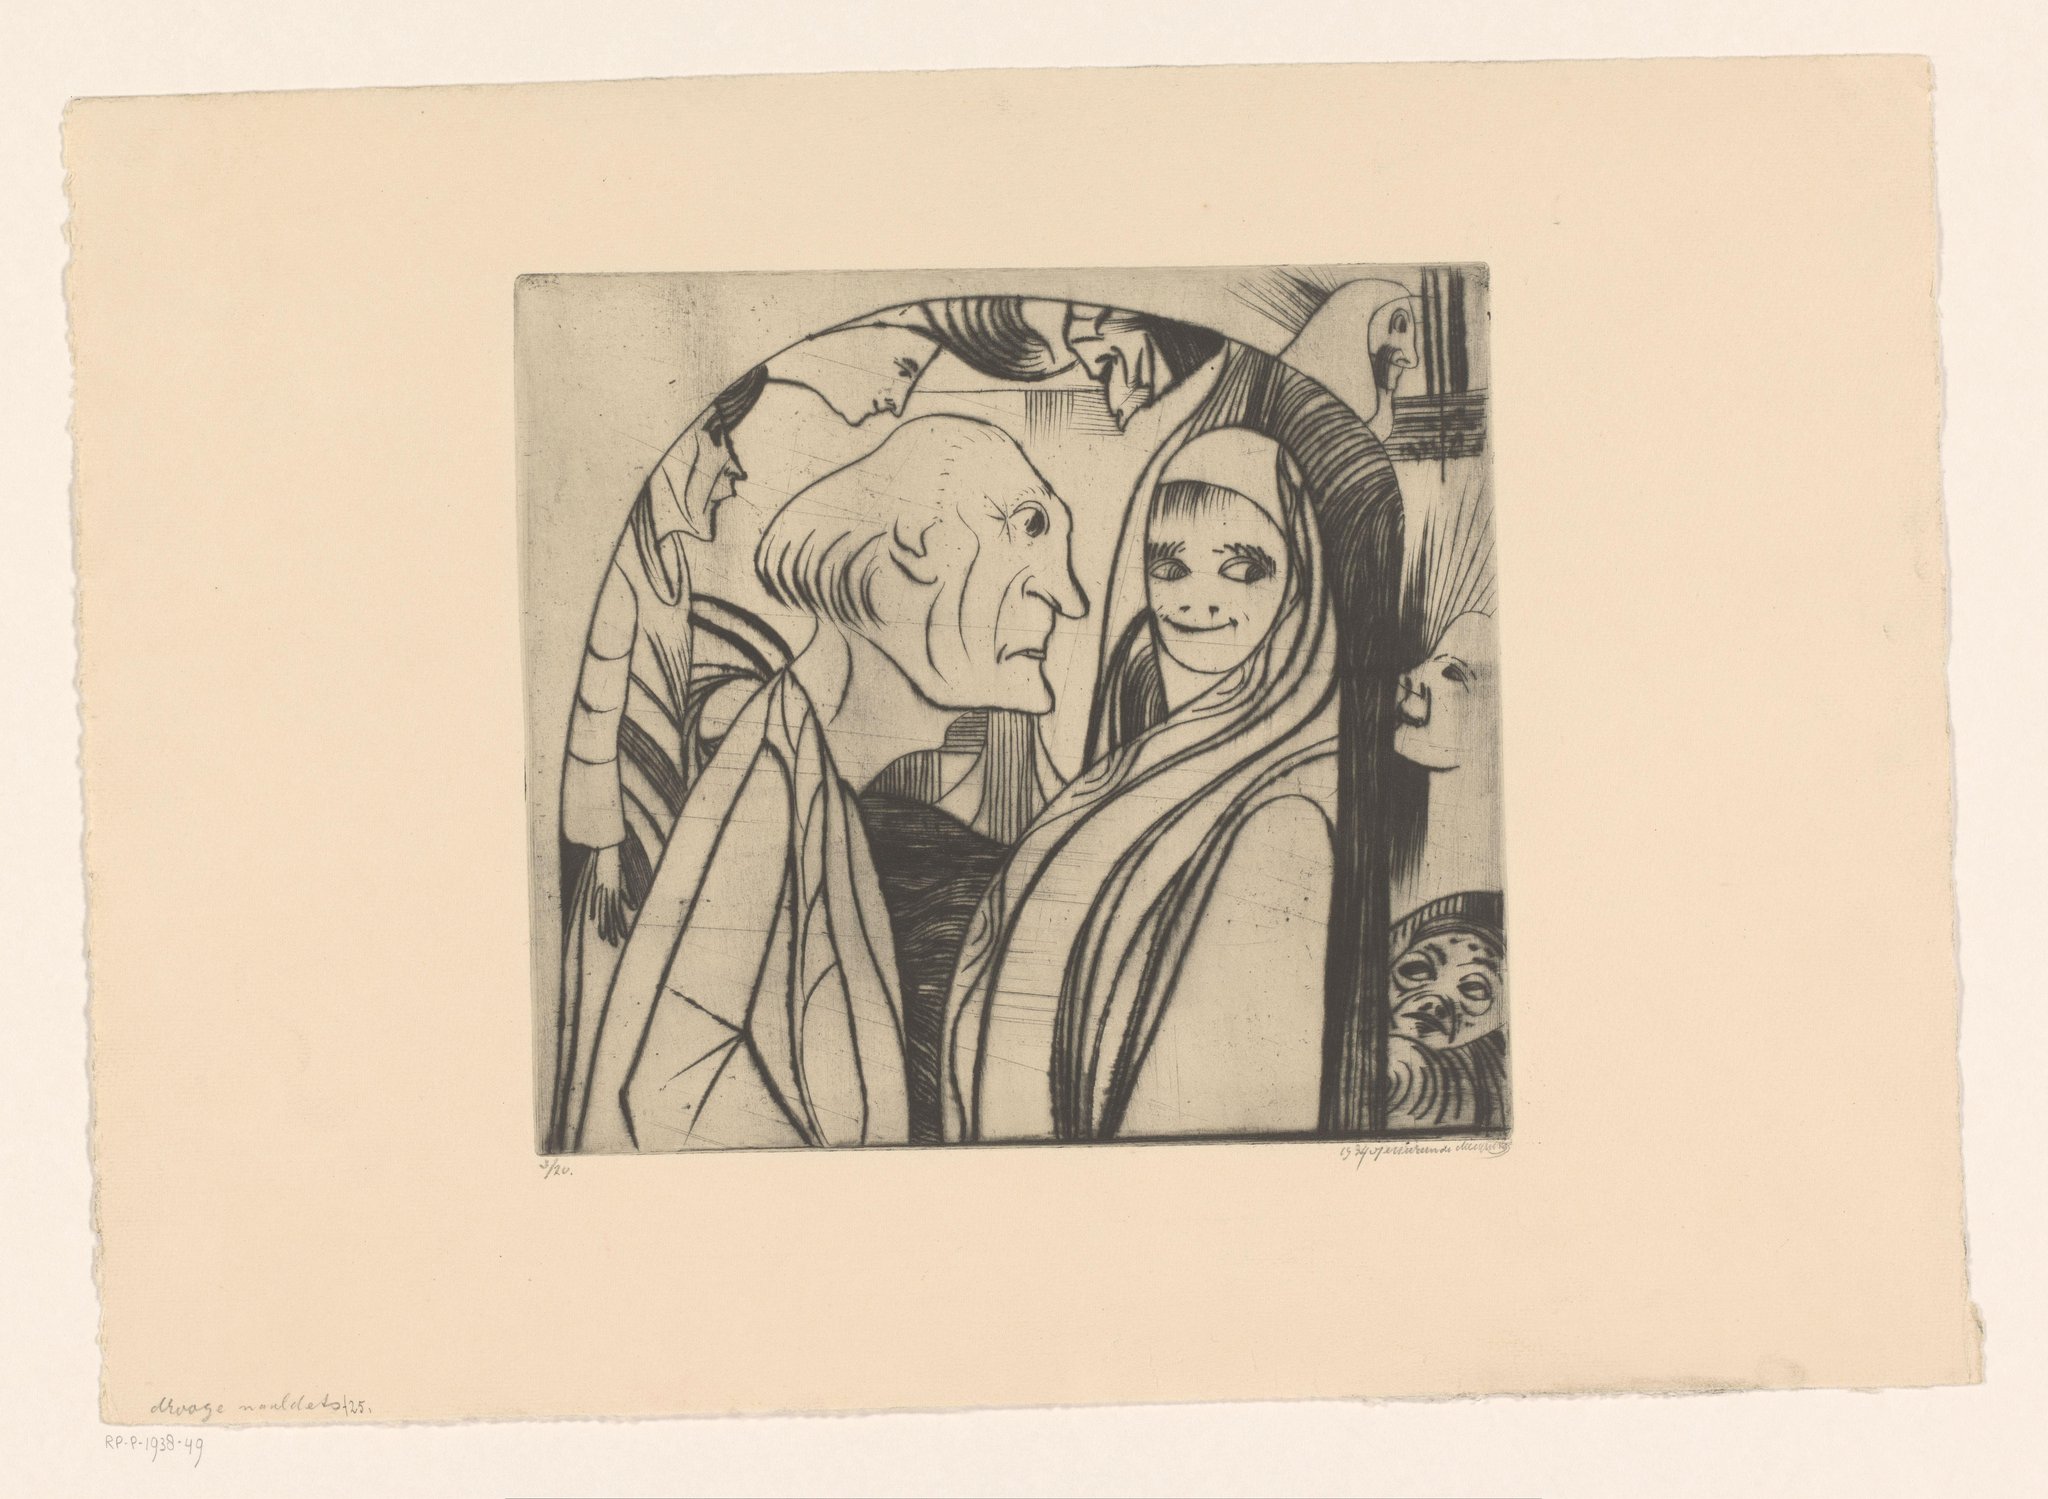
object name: print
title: Man en vrouw in een boog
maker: samuel jessurun de mesquita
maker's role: draughtsman, print maker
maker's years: 1868-1944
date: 1934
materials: paper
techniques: drypoint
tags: caricatures (human types), smiling, old man, baldness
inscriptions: collector's mark: Lugt 2228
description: Om de man en de vrouw heen zes karikaturale figuren.